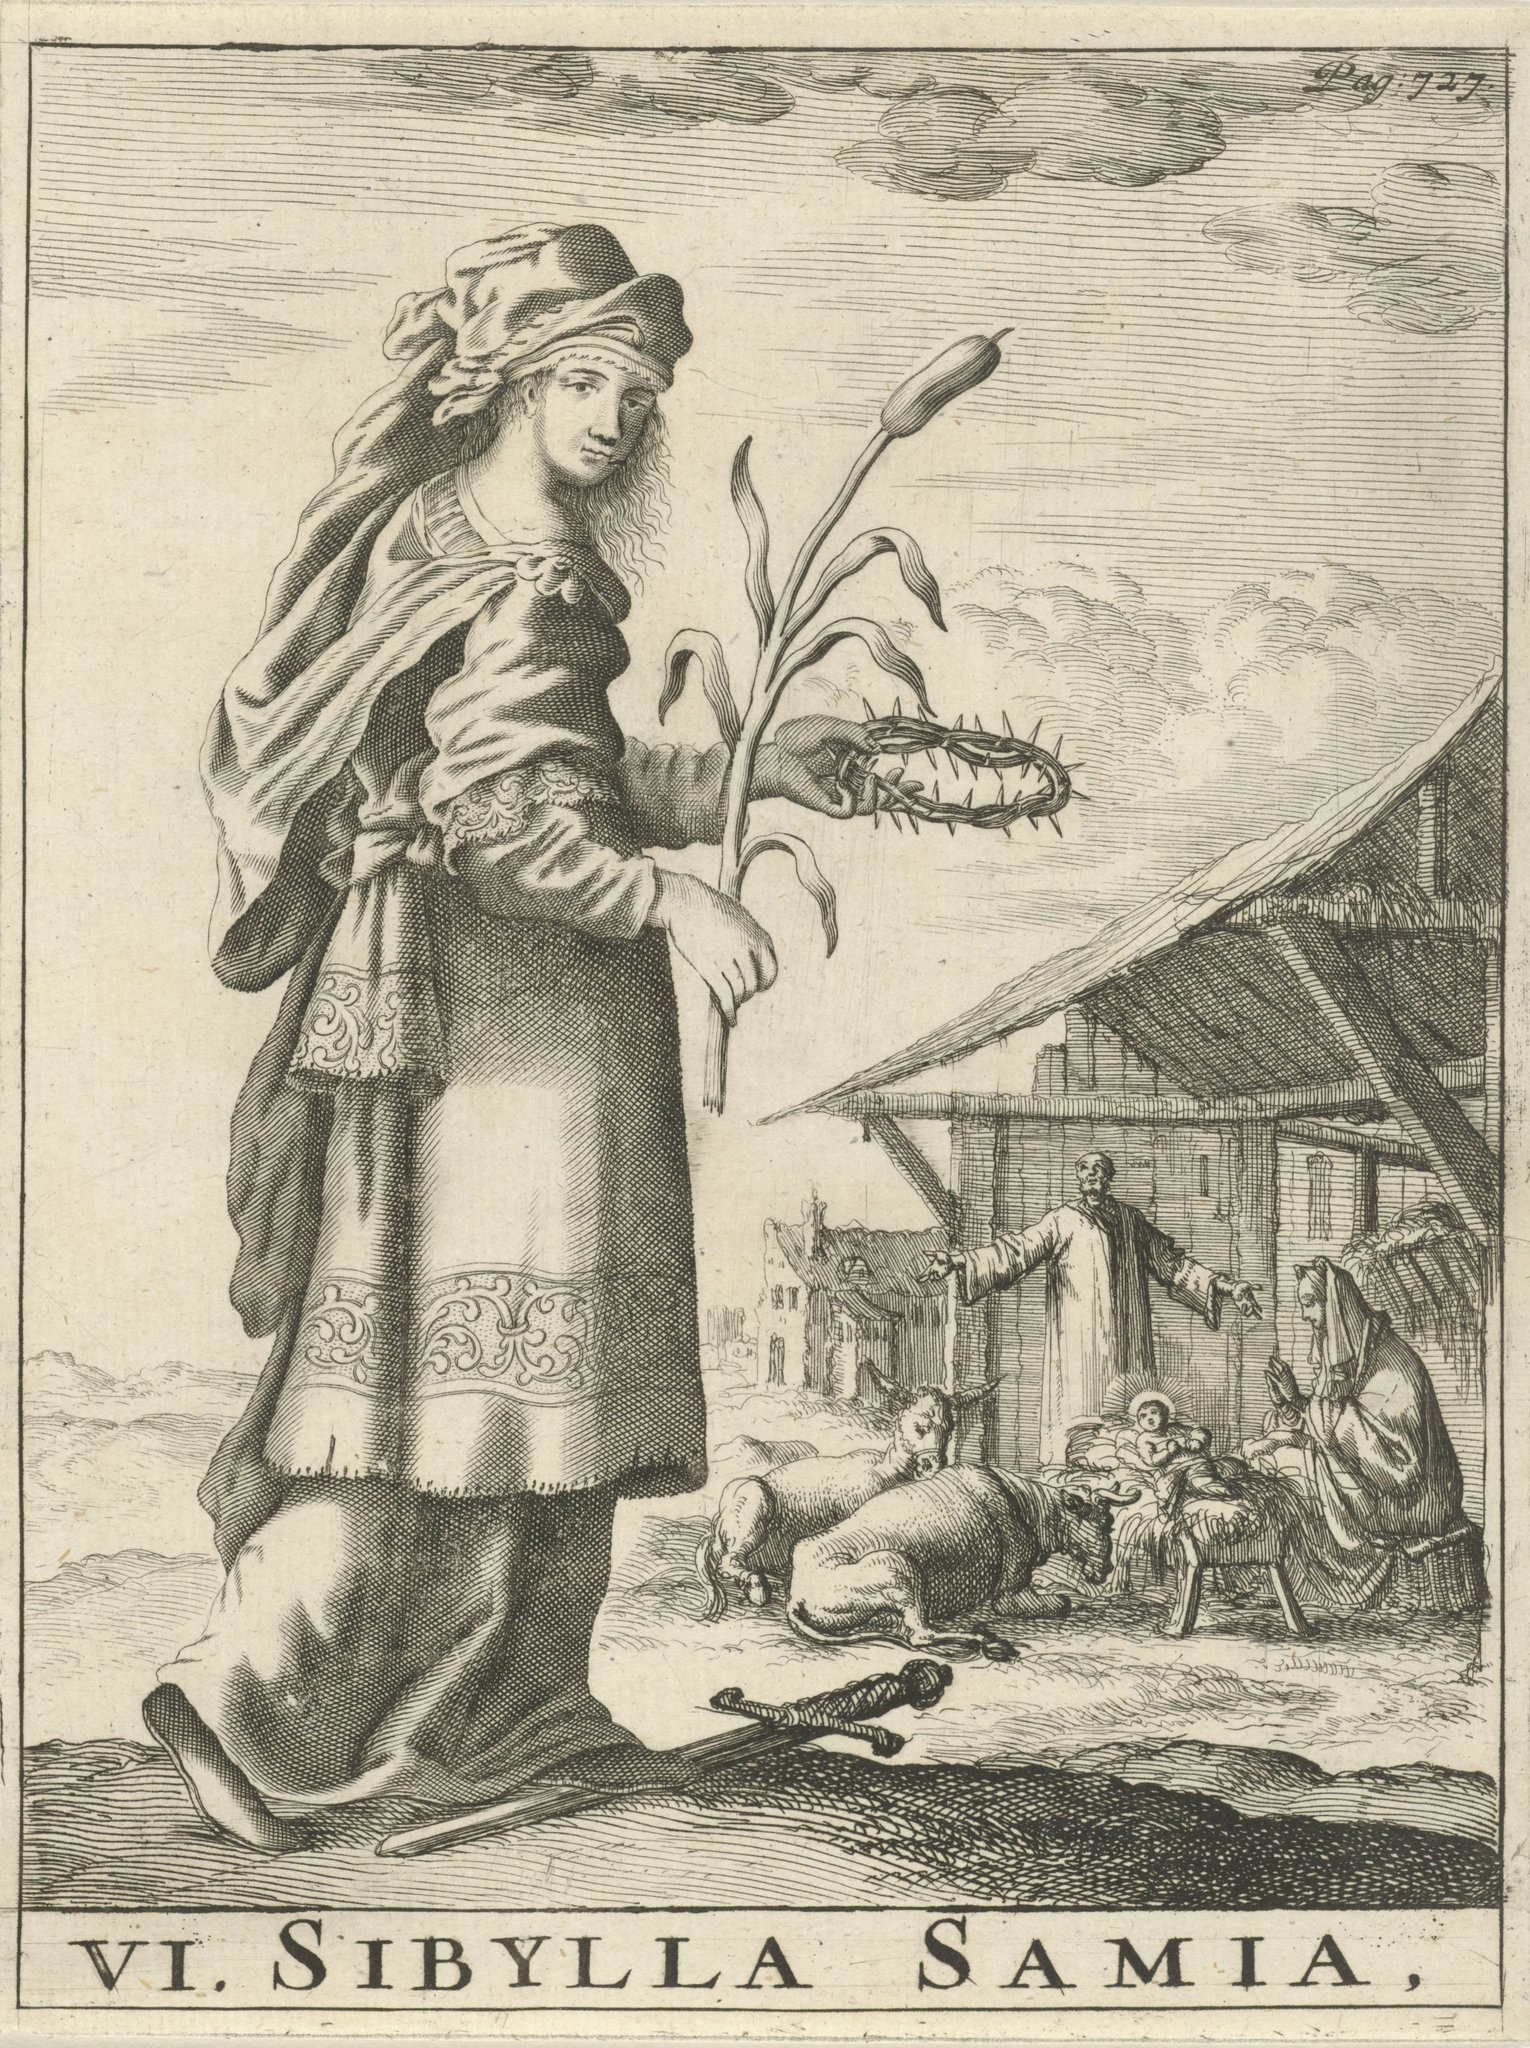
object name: book illustration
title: Sibylla Samia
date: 1684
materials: paper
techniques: engraving, etching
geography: amsterdam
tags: samian sibyl, mary, joseph and the new-born christ (nativity)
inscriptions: collector's mark: Lugt 2228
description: Sibille van Samos. Op de achtergrond een stal met Jozef, Maria en het pasgeboren Christuskind. Prent rechtsboven gemerkt: Pag: 727.